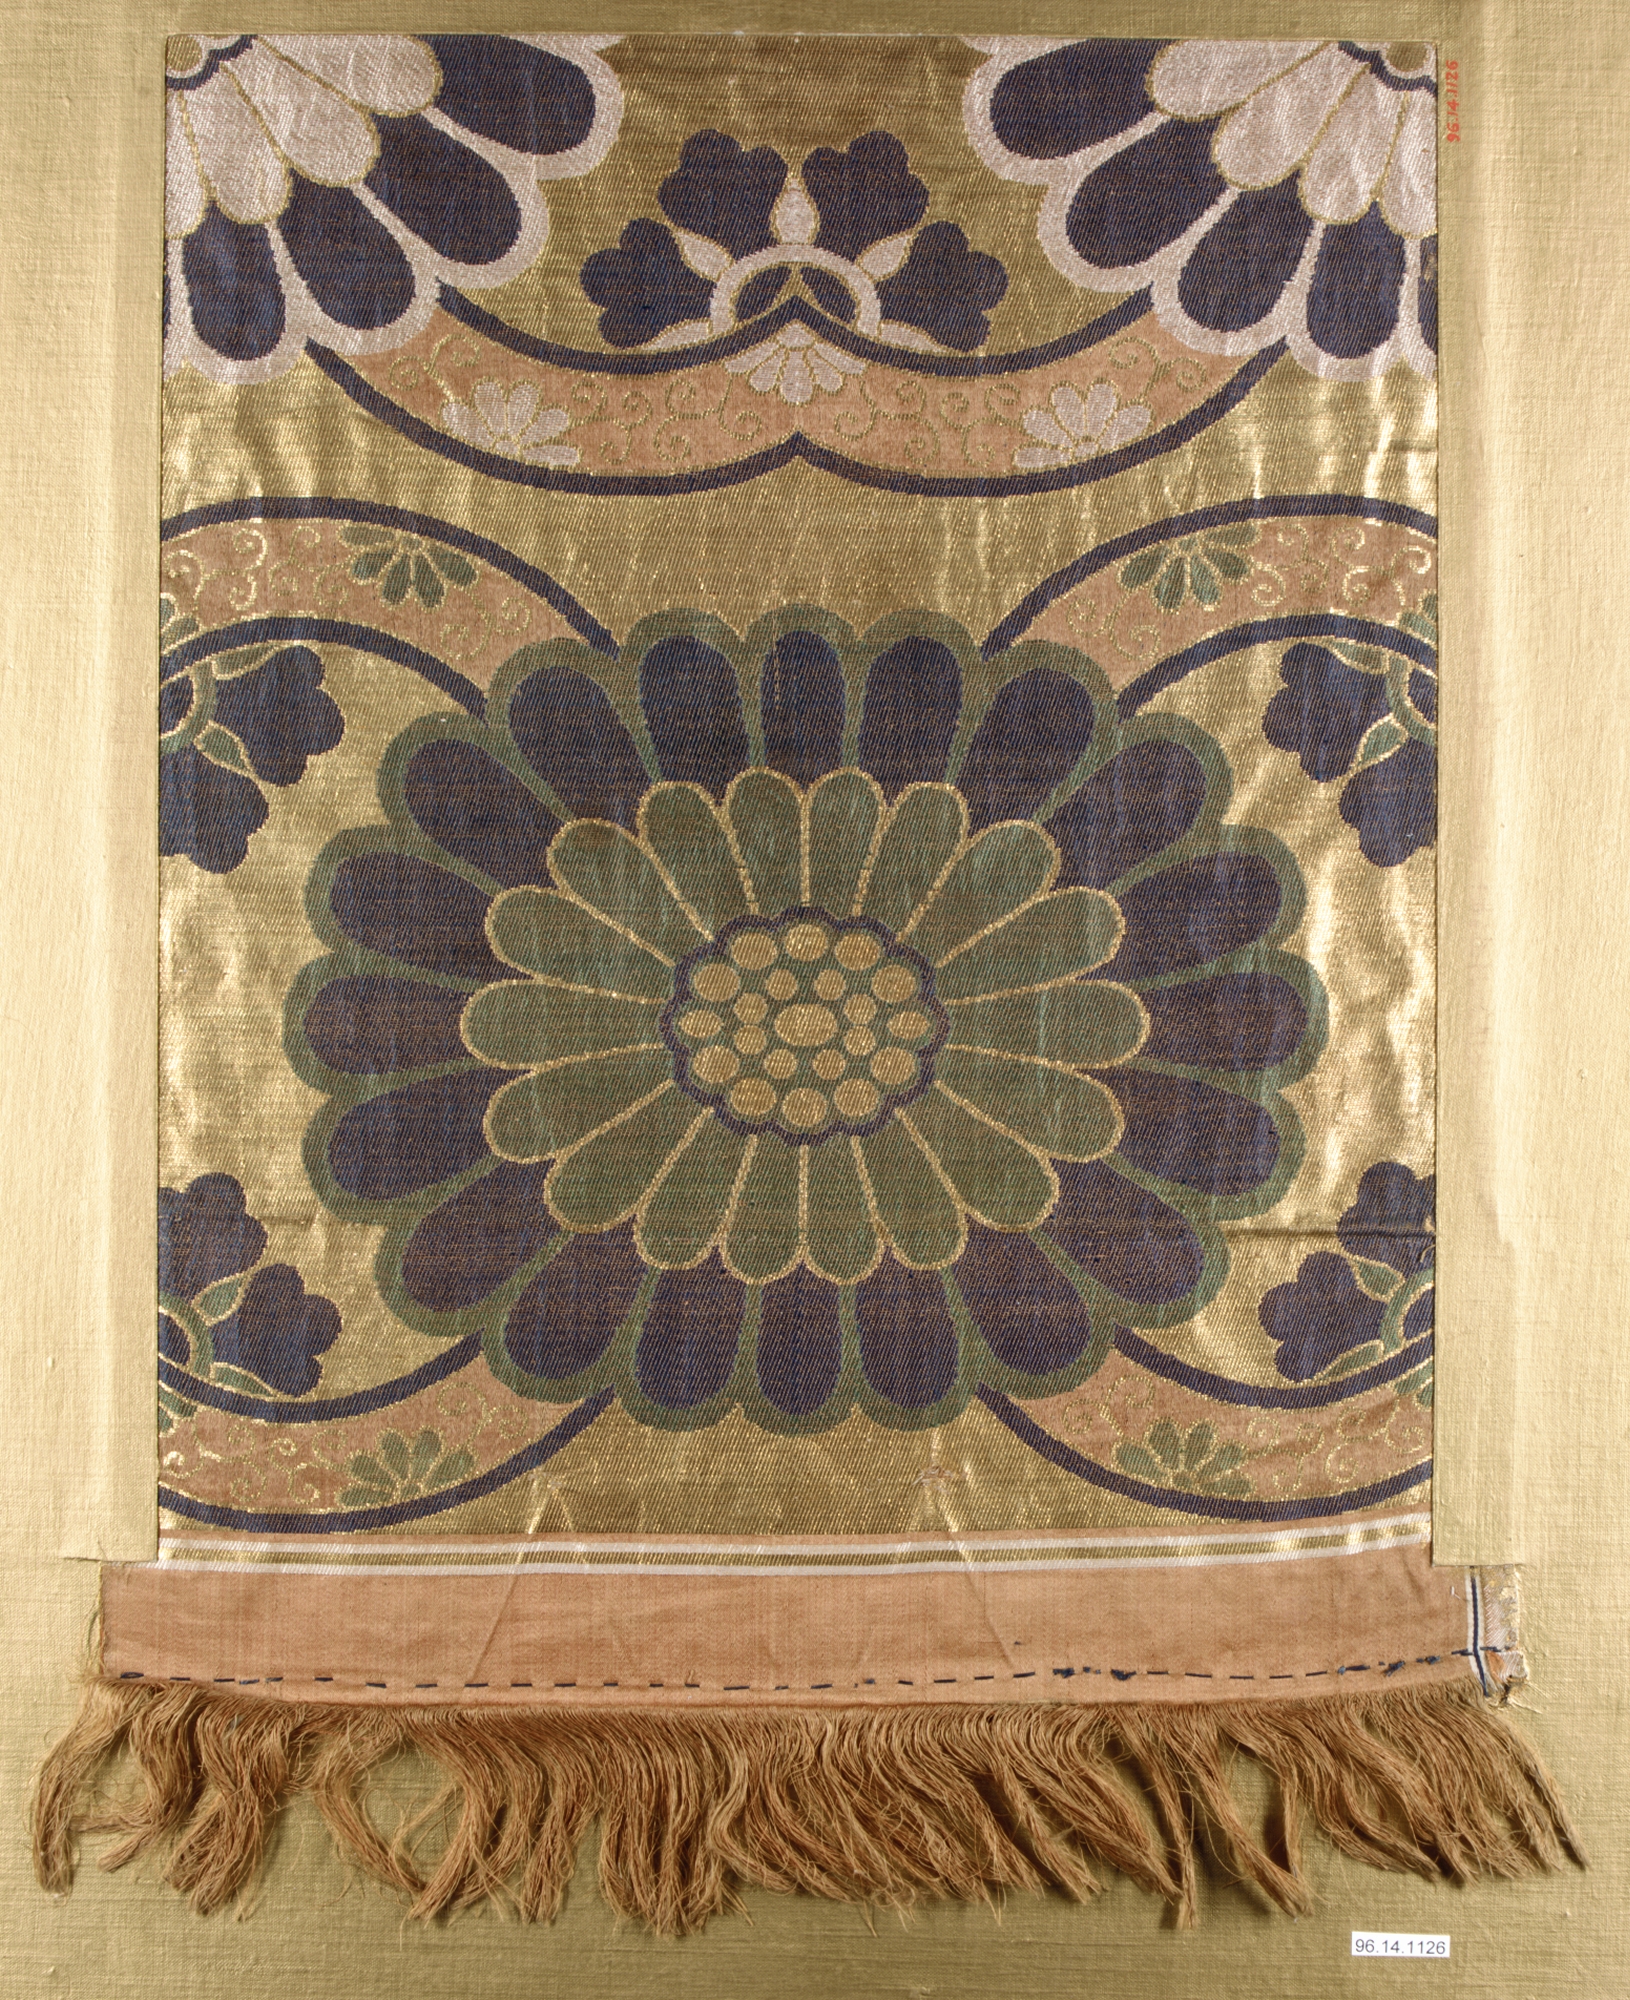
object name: piece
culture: japanese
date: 1701-1900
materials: silk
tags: flowers